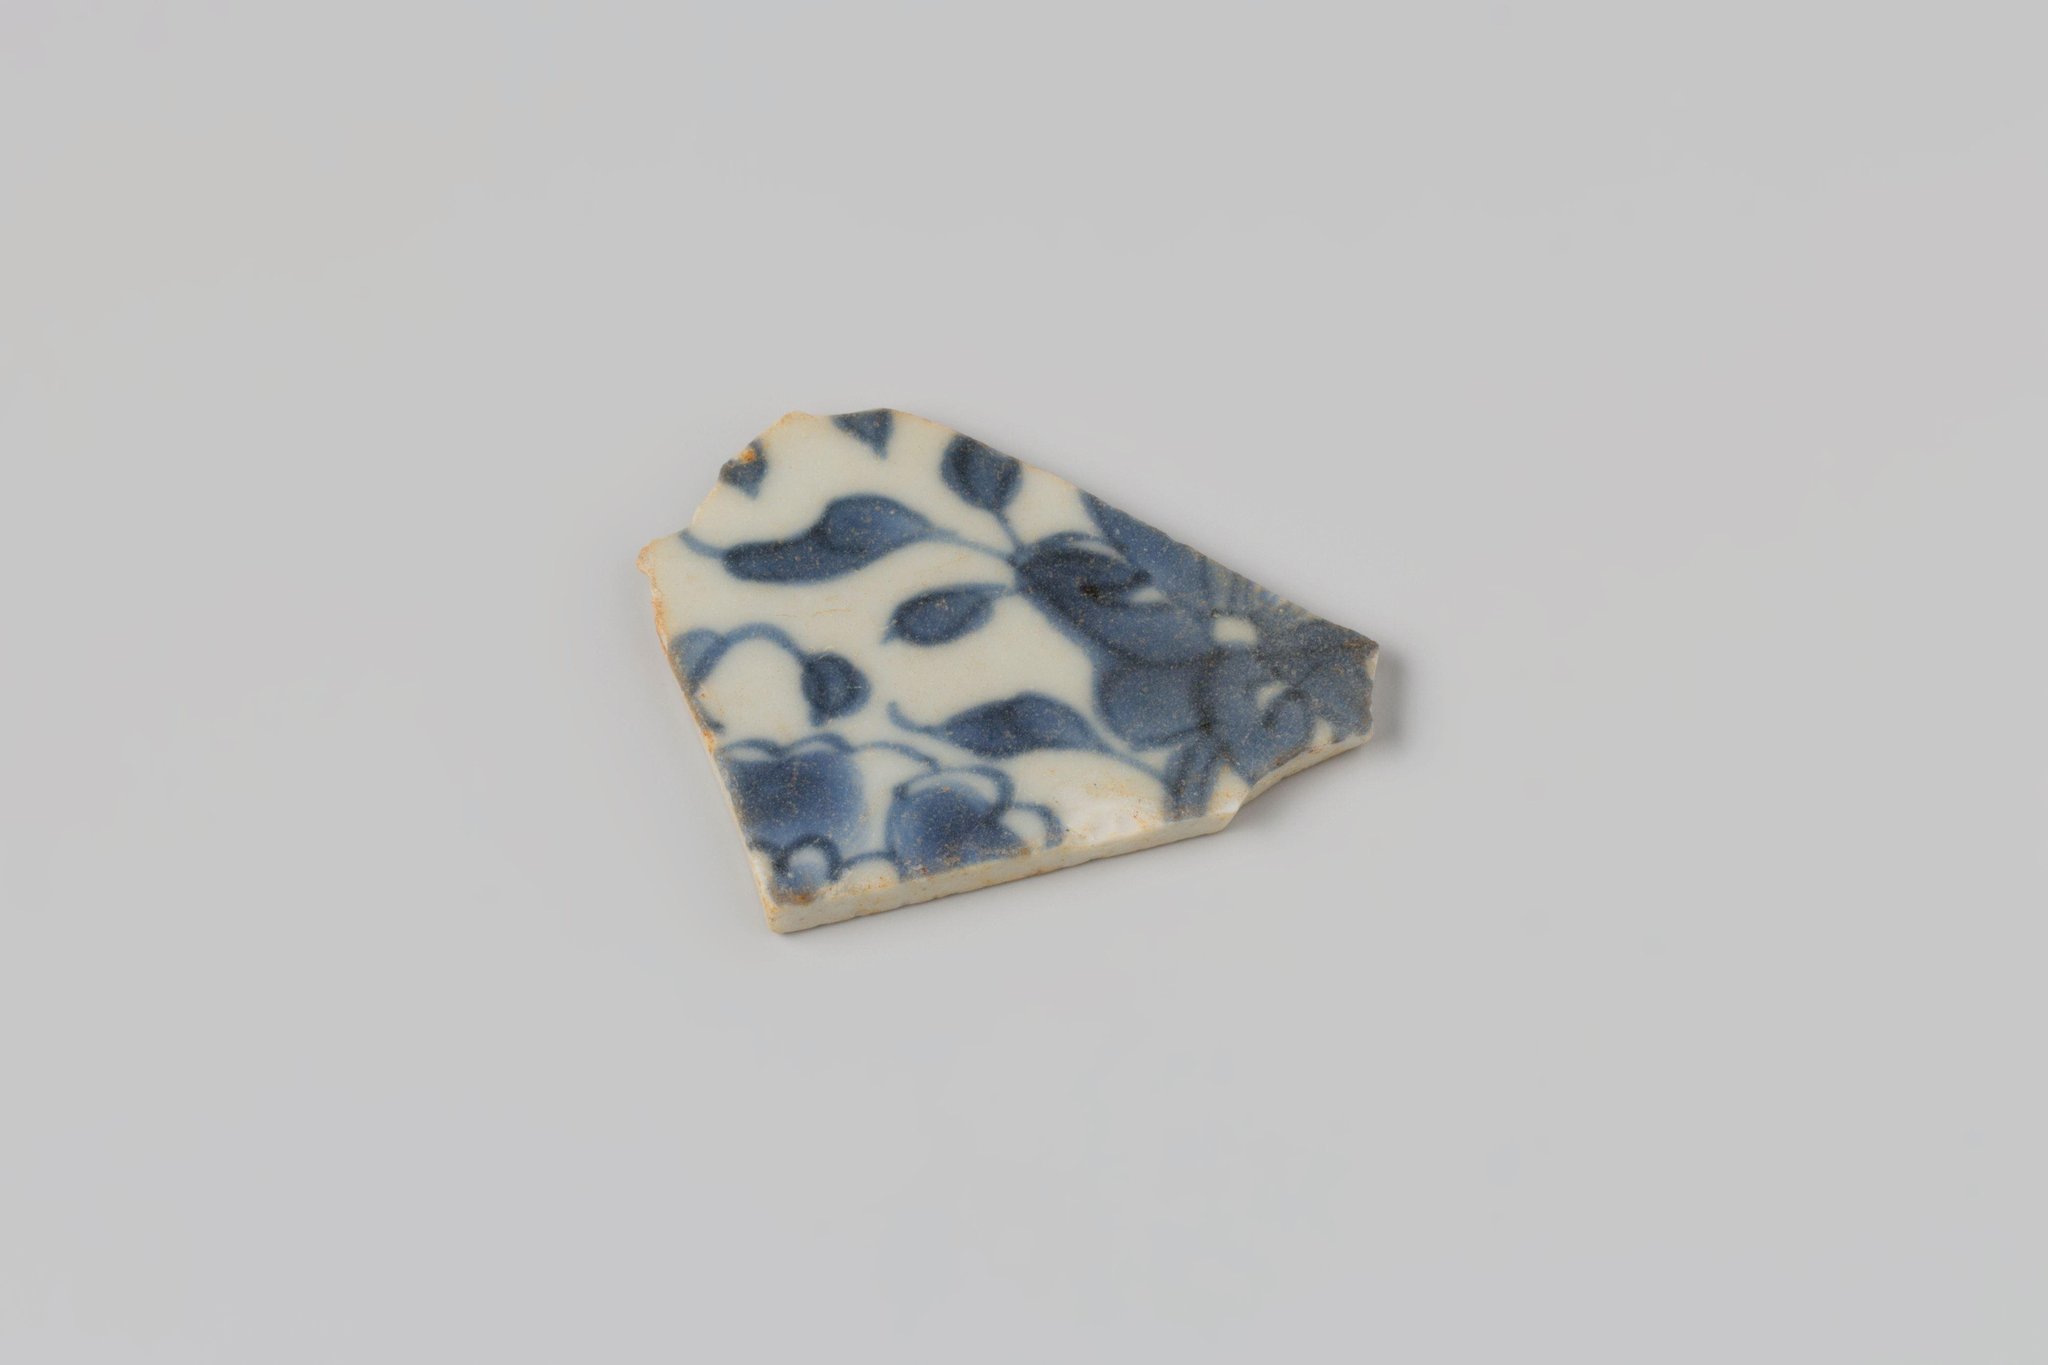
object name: plate dish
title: Scherf van een bord uit het wrak van de Oost-Indiëvaarder Hollandia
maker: Anonymous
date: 1700-1743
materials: porcelain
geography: netherlands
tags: verenigde oostindische compagnie, hollandia (schip), annet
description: Porcelain, plate, type 3; fragm of base or rim, sim. NG 1980-27H3202c.